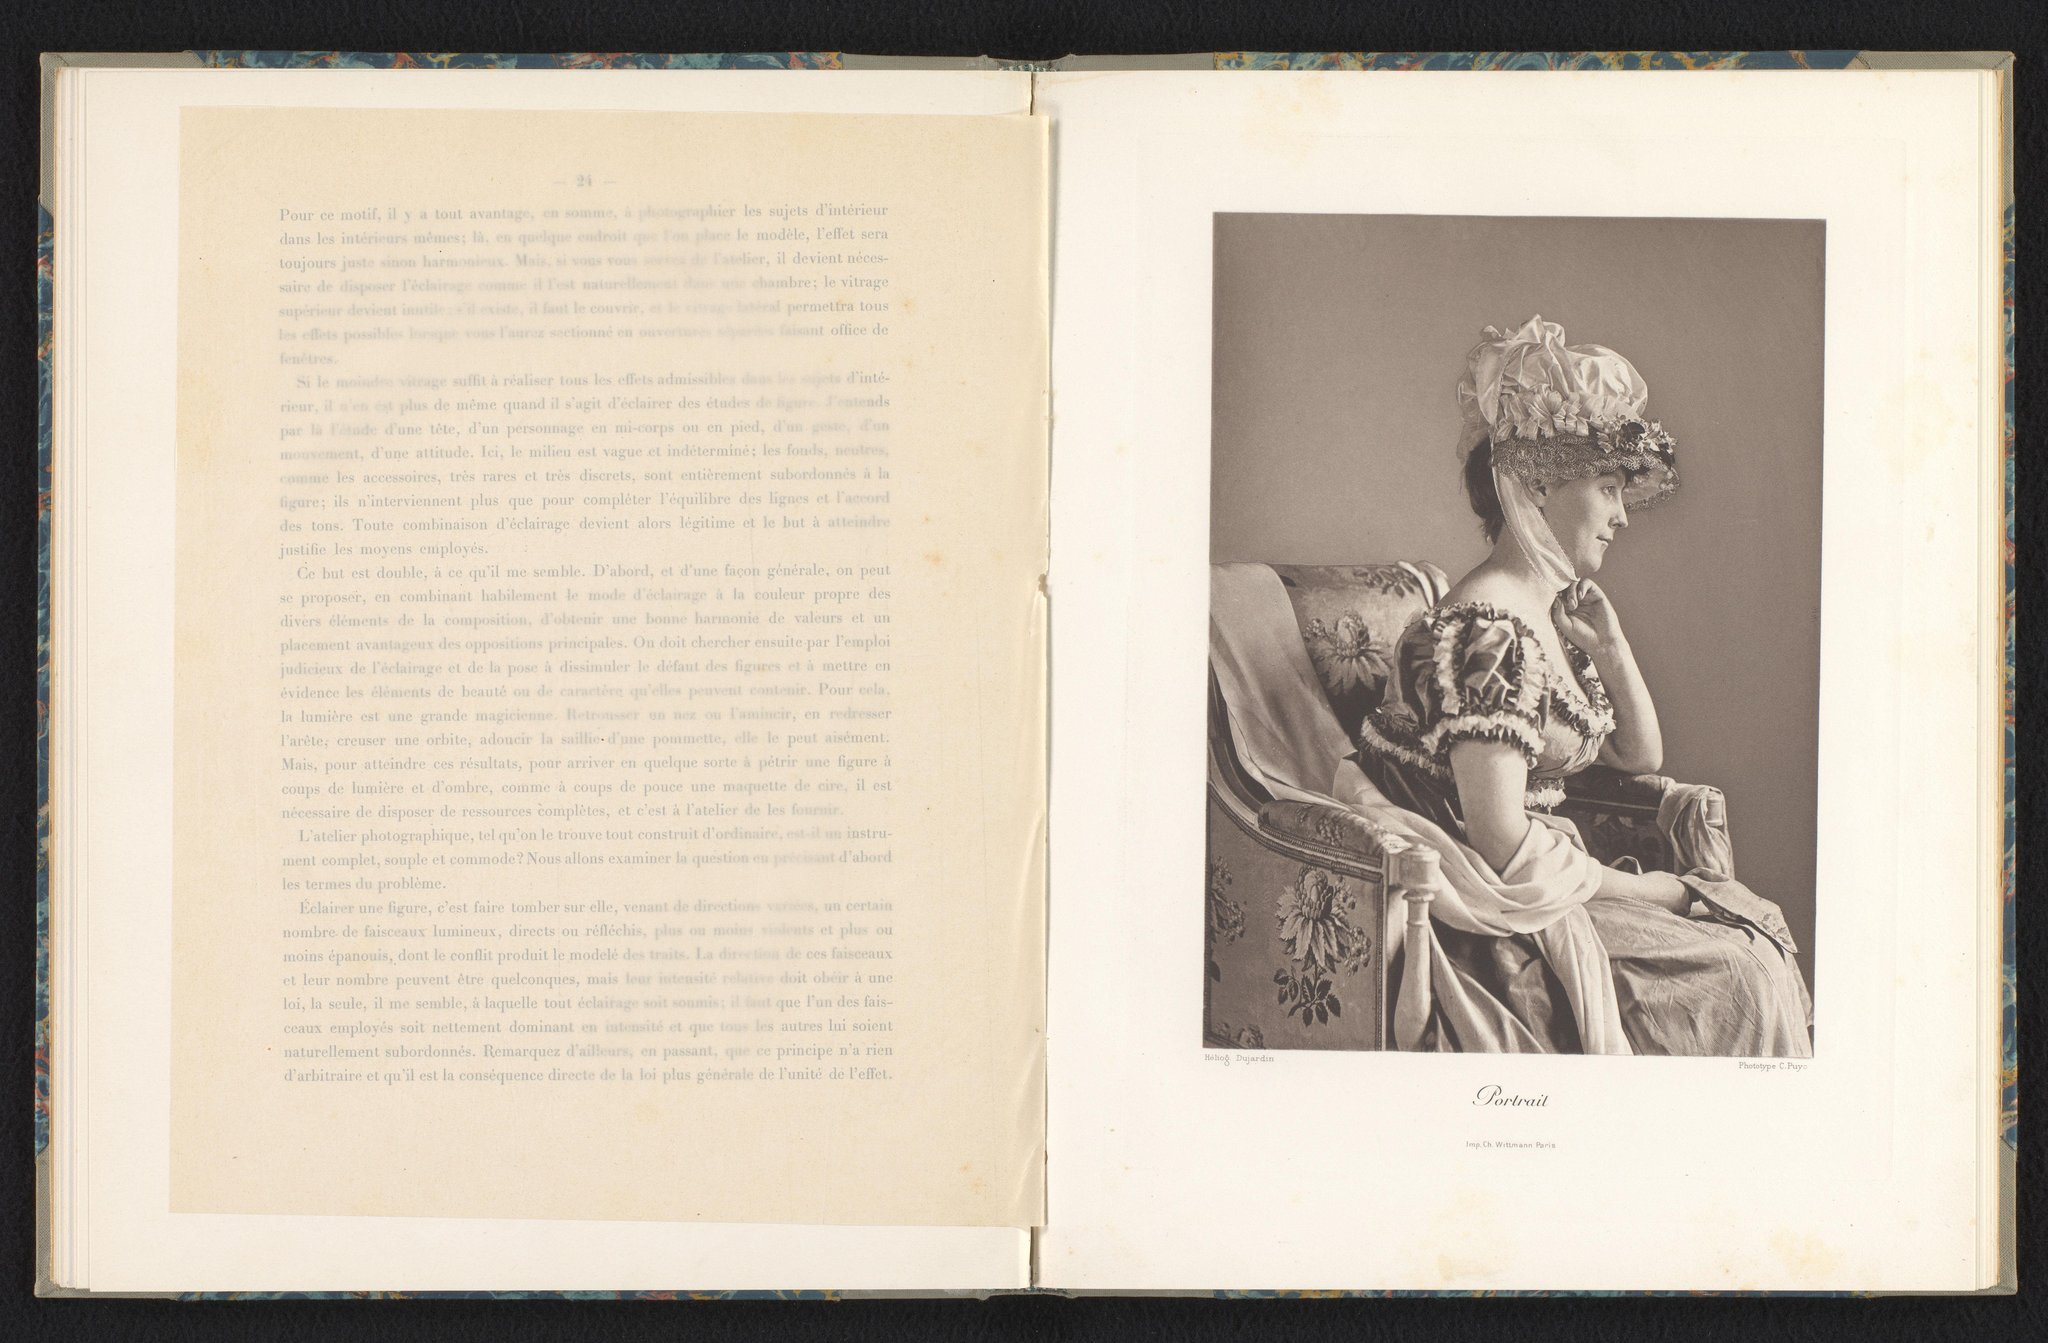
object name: photomechanical print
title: Portrait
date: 1891-1896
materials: paper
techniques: photoaquatint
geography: france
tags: adult woman, historical persons not known by name - bb - woman, head-gear: hat, chair